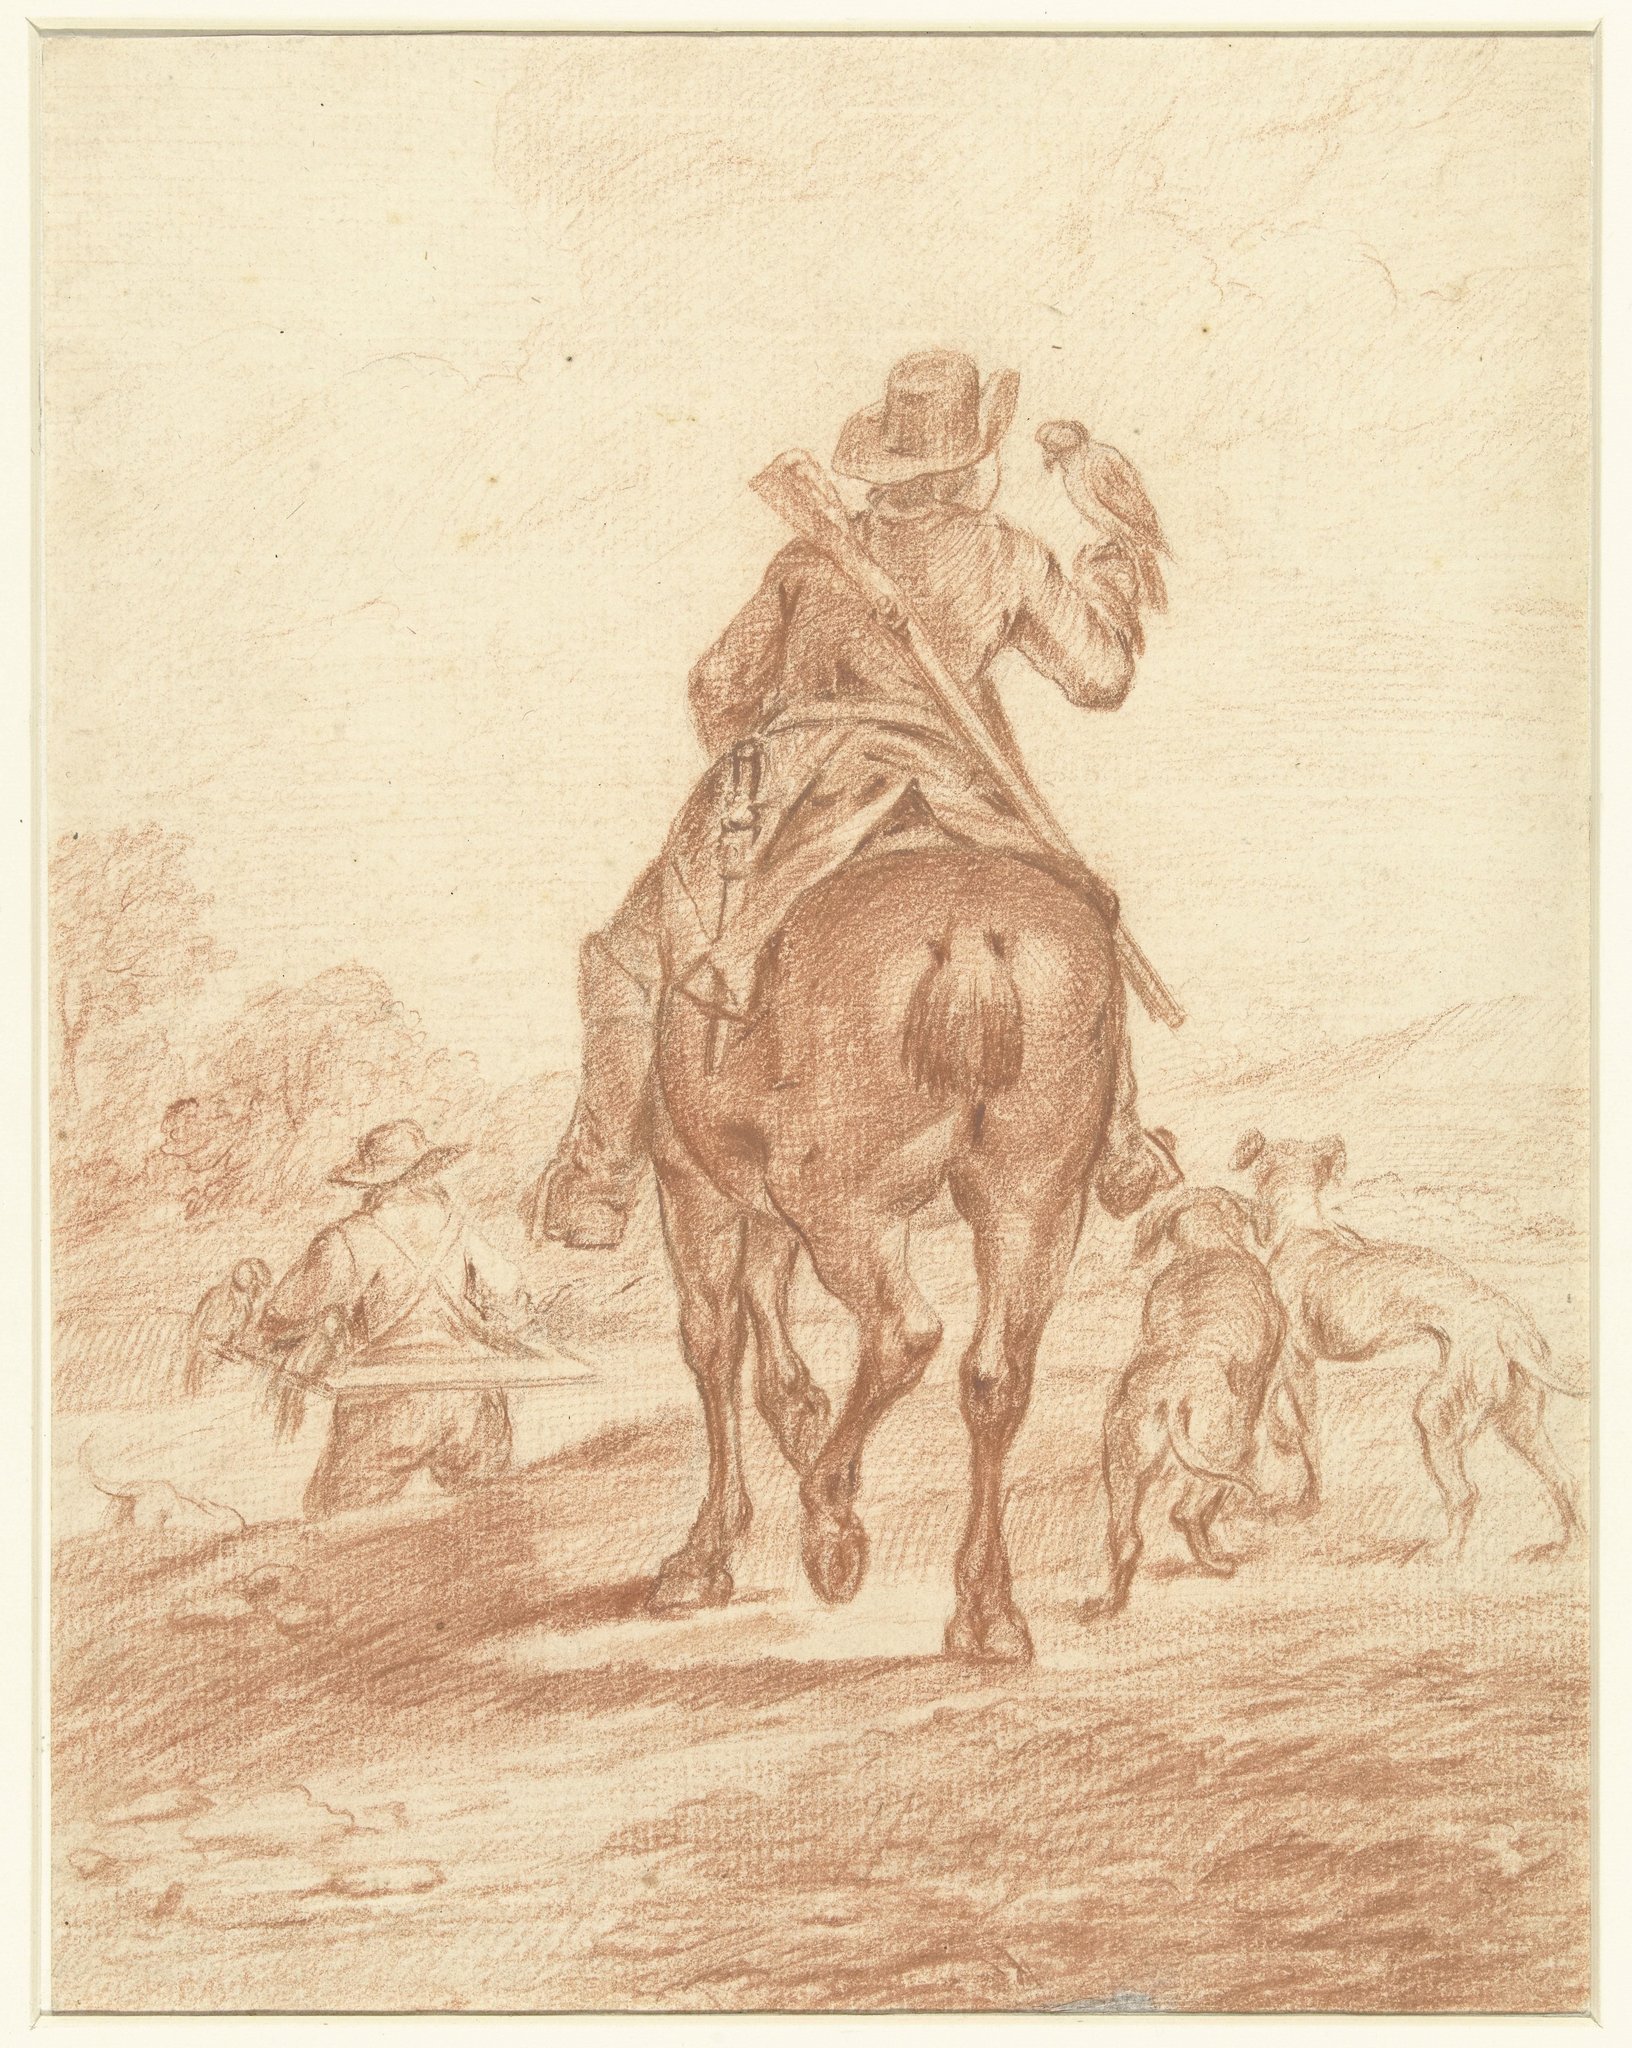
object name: drawing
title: Twee valkenjagers, van achteren gezien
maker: Anonymous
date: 1700-1800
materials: chalk, paper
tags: spoils of the hunt, game, venison (+ hunting with falcon, hawk; falconry)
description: Twee valkenjagers, een te paard en een te voet, van achteren gezien.